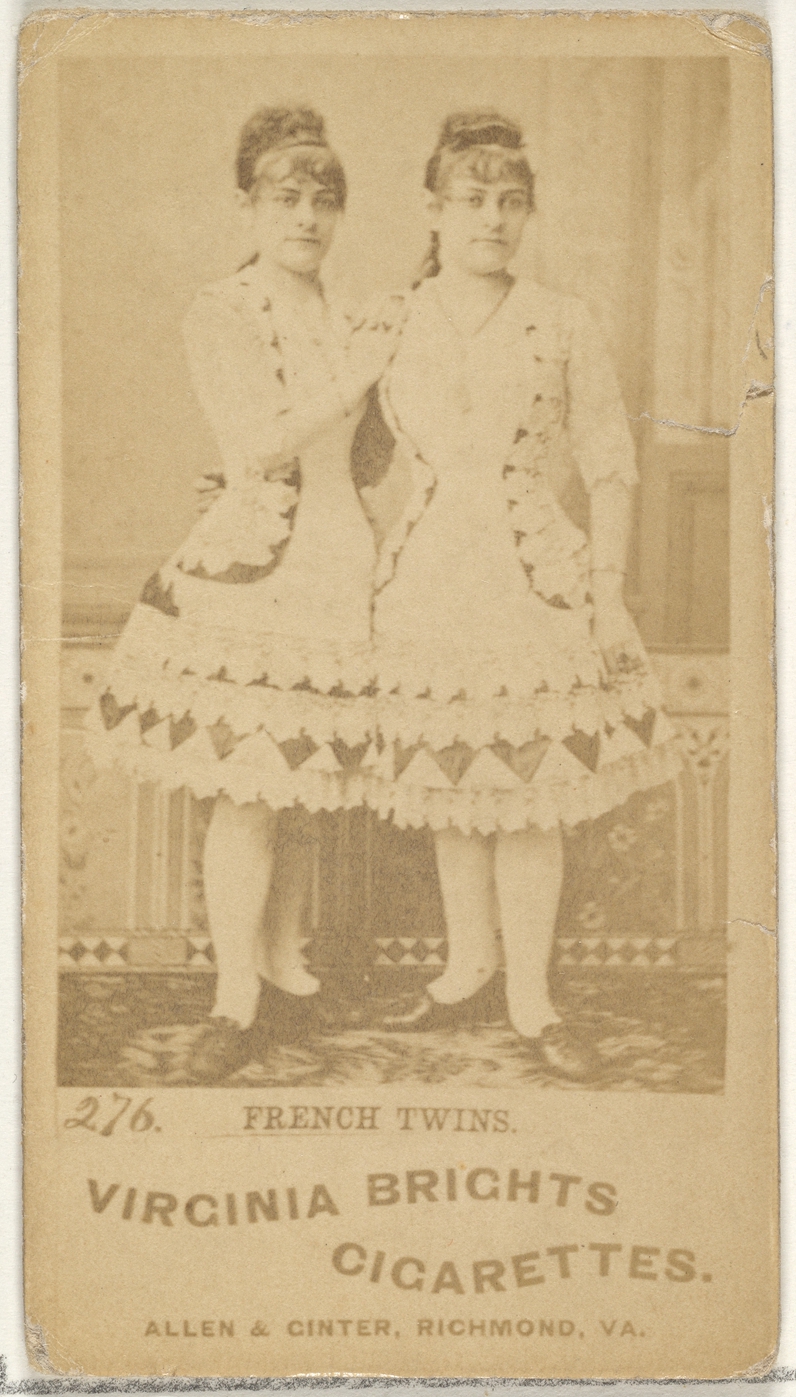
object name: photograph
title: Card 276, French Twins, from the Actors and Actresses series (N45, Type 1) for Virginia Brights Cigarettes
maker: allen & ginter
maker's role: publisher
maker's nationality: american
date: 1888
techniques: albumen silver print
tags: portraits,women,actresses